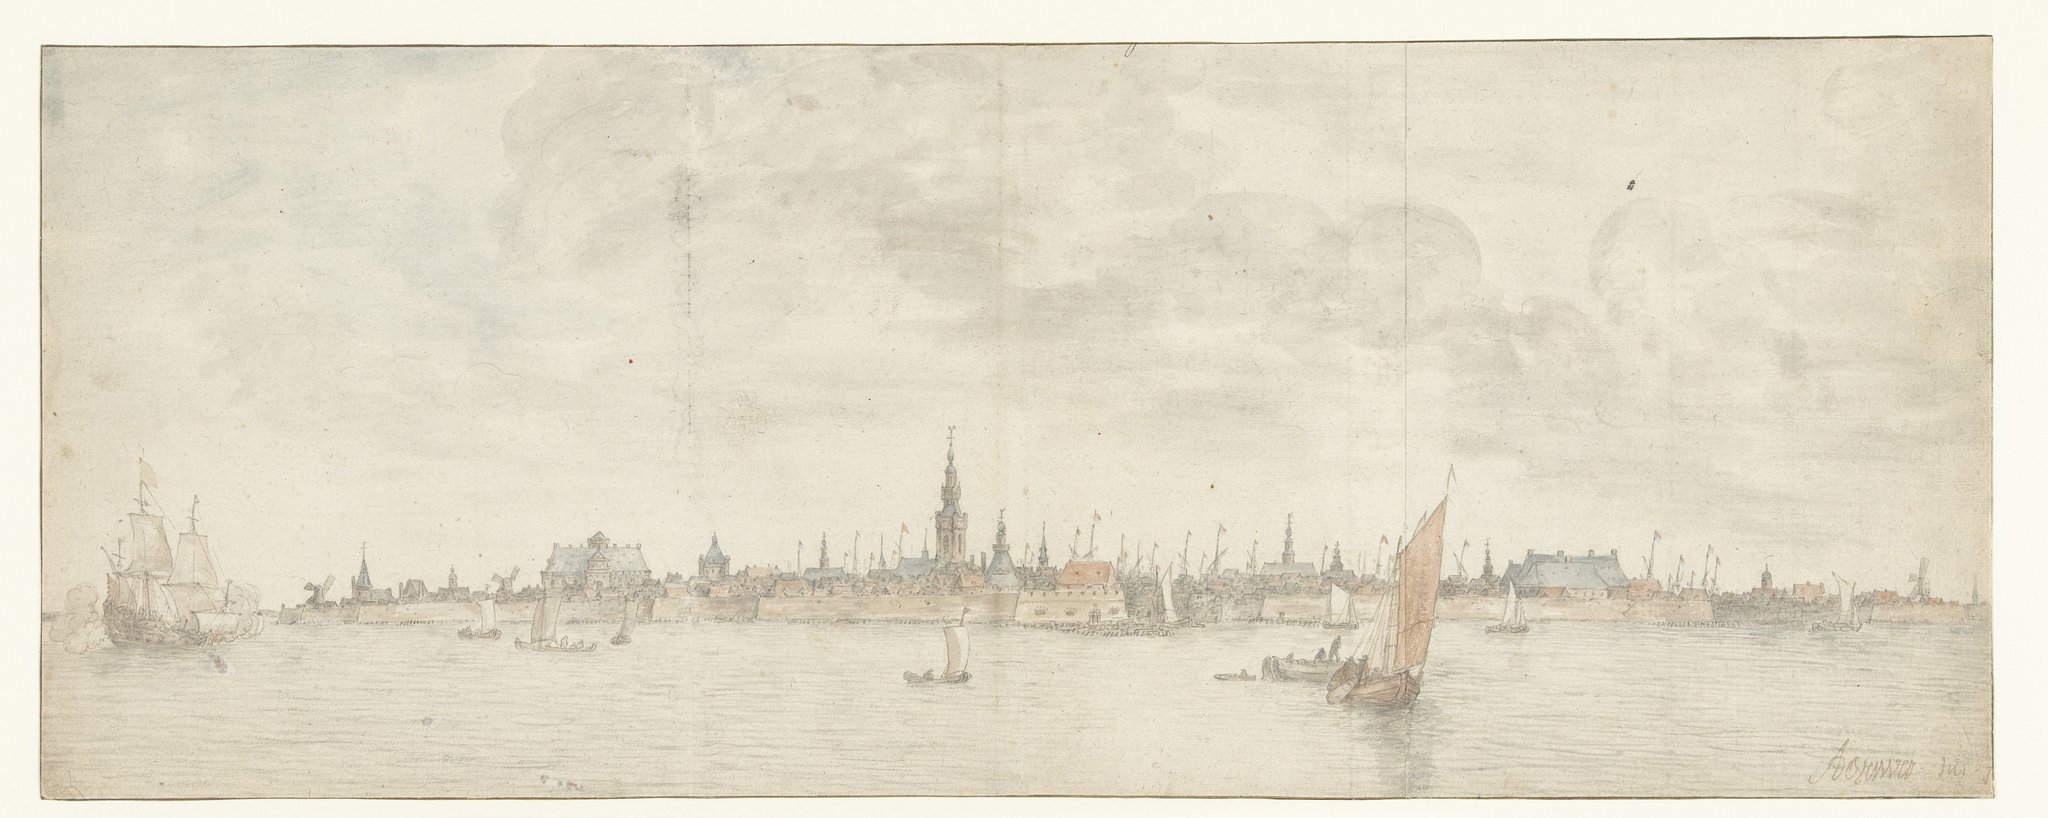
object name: drawing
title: Gezicht op Vlissingen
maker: abraham de verwer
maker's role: draughtsman, painter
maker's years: 1585-1650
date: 1600-1650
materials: paper, pencil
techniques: brush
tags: prospect of city, town panorama, silhouette of city, flushing